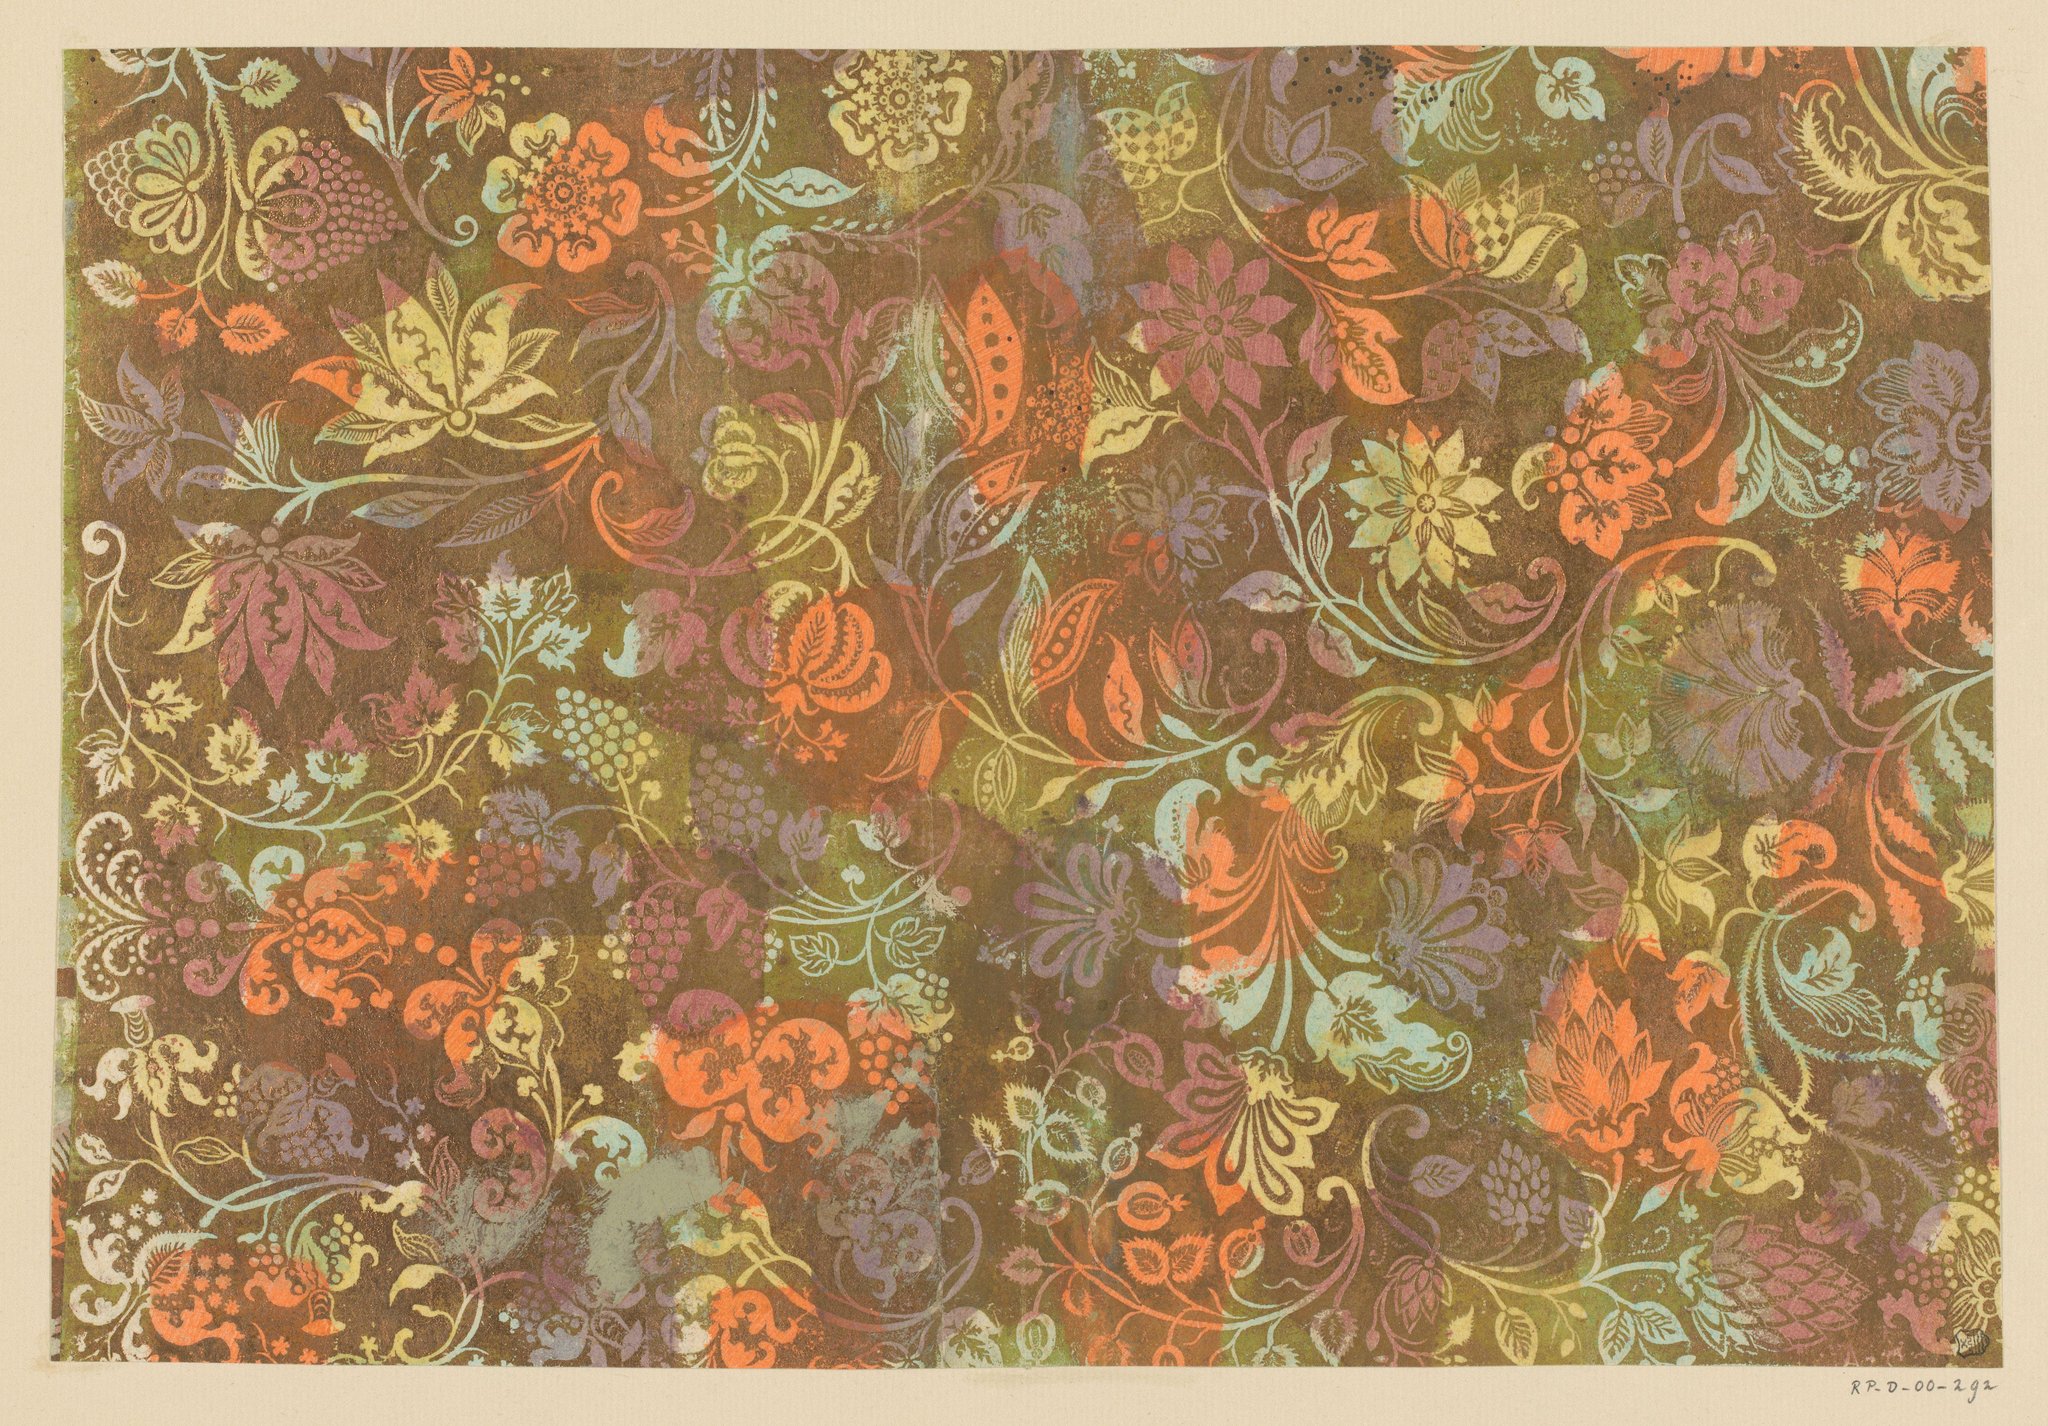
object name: brocade paper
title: Blad met ranken met bladeren, bloemen en vruchten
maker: andreas steber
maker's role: ontwerper sierpapier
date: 1720-1750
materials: gold leaf, paint, paper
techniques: relief print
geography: nördlingen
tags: ornament derived from plant forms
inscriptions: collector's mark: Lugt 2760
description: Blad met ranken met bladeren, bloemen en vruchten.